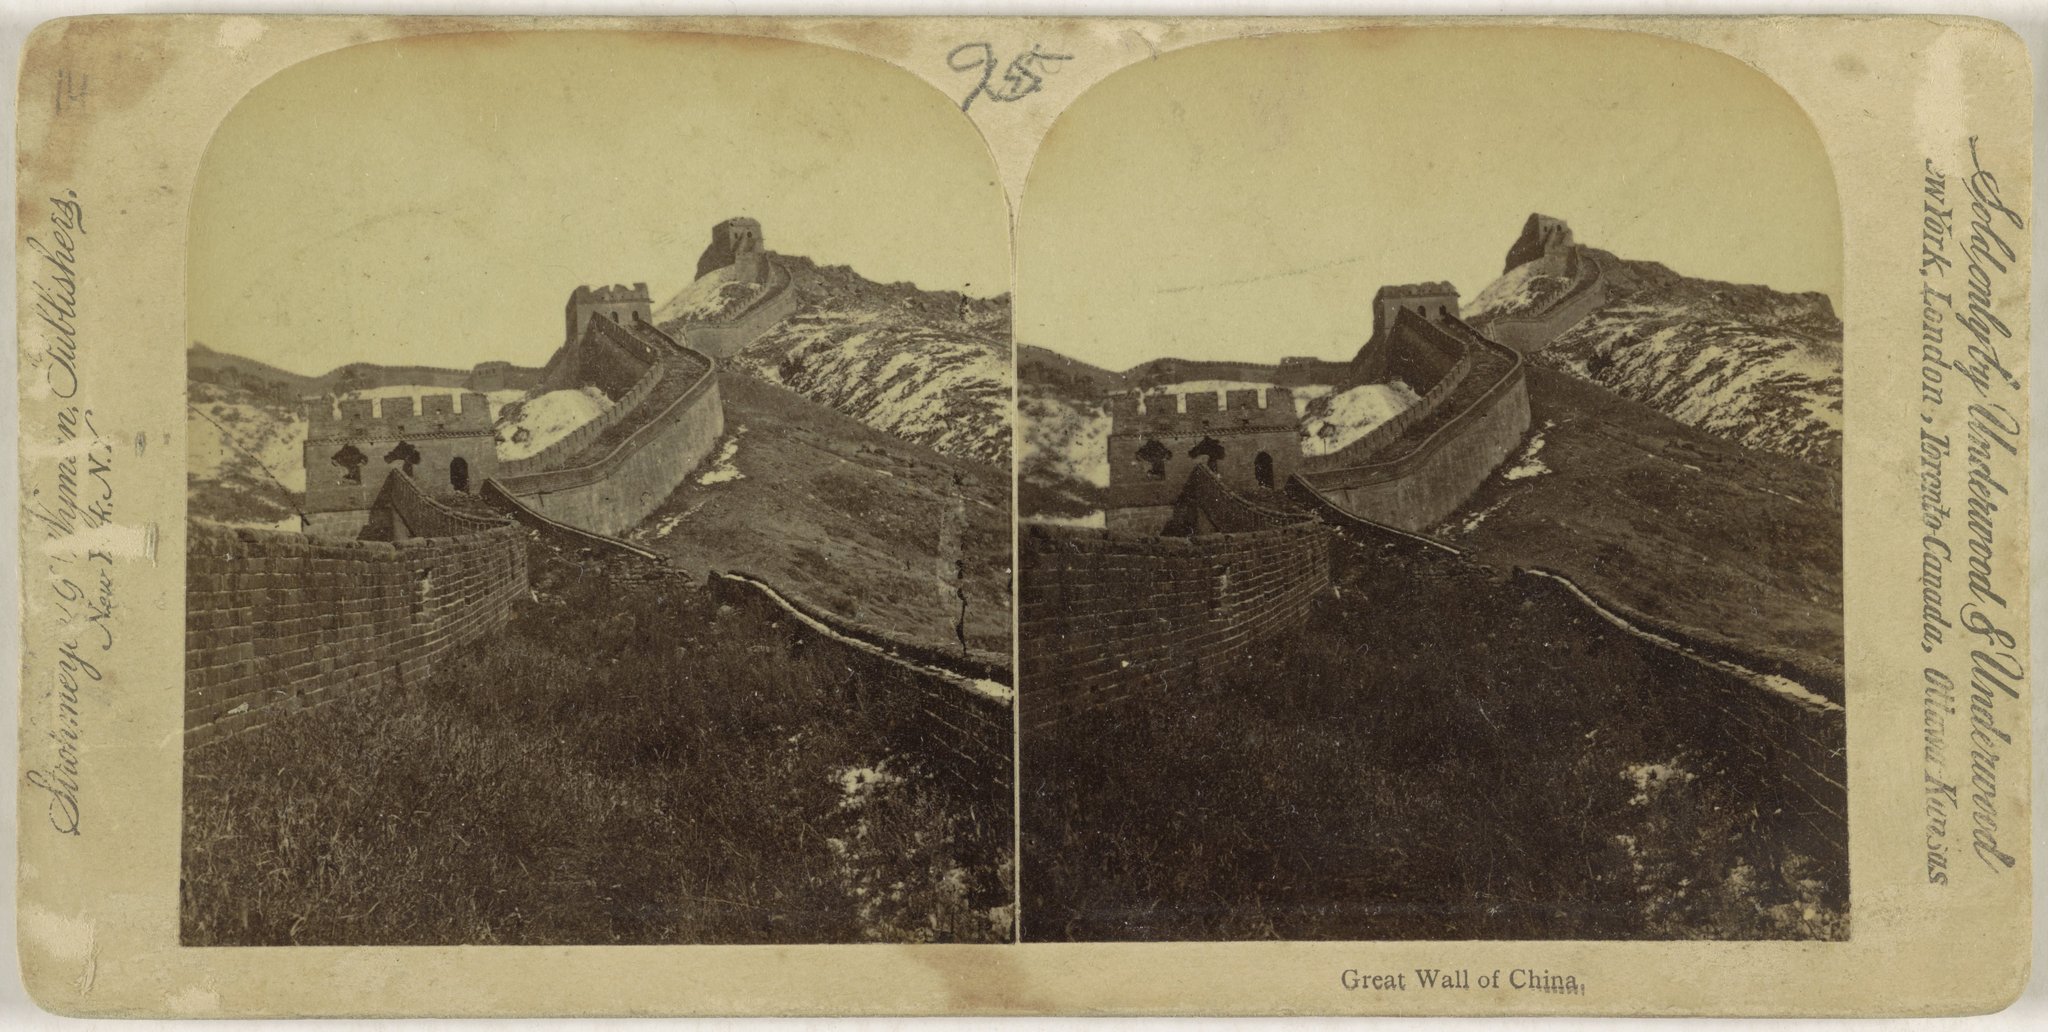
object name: stereograph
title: Tiger Hill Pagoda, the "Leaning Tower" of Soo-chow (1300 years old) - full view - China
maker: Anonymous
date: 1900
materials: cardboard, paper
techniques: albumen print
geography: new york city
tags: temple, shrine ~ hinduism, buddhism, jainism, tiger hill pagoda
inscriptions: inscription: ‘SUN SCULPTURE/ UU/ TRADEMARK/ Works and Studios/ Arlington, N.J. Westwood, N.J. Washington, D.C.’, title: ‘Tiger Hill Pagoda, the "Leaning Tower" of Soo-chow (1300 years old) - full view - China.’, number: ‘34’, copyright notice: ‘Copyright 1900 by Underwood & Underwood.’